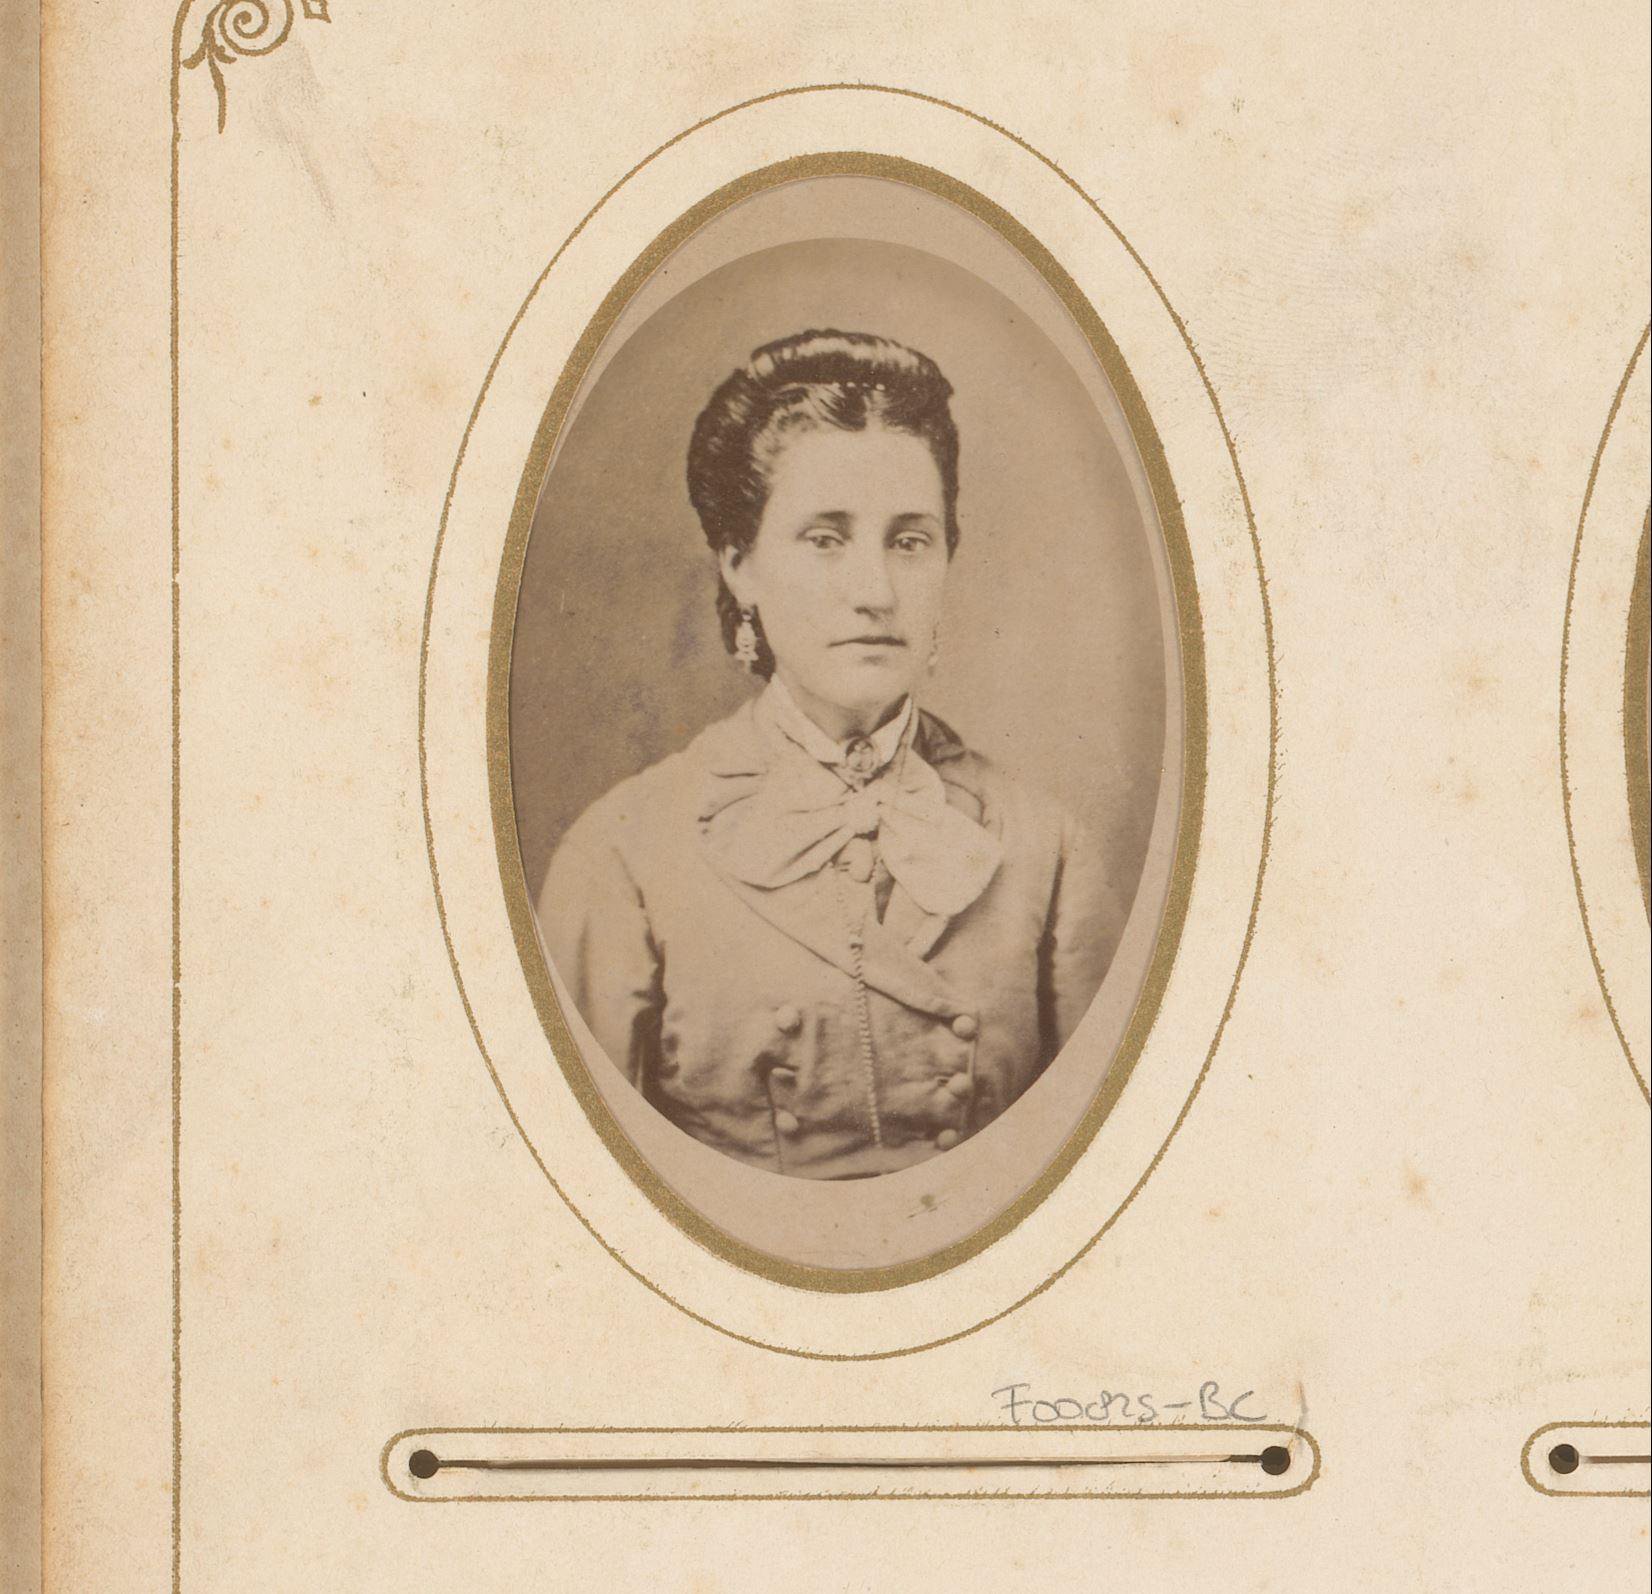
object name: photograph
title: Portret van een vrouw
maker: jan george mulder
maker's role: fotograaf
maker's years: 1816-1895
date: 1865-1887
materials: cardboard, photographic support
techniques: albumen print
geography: haarlem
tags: historical persons - bb - woman